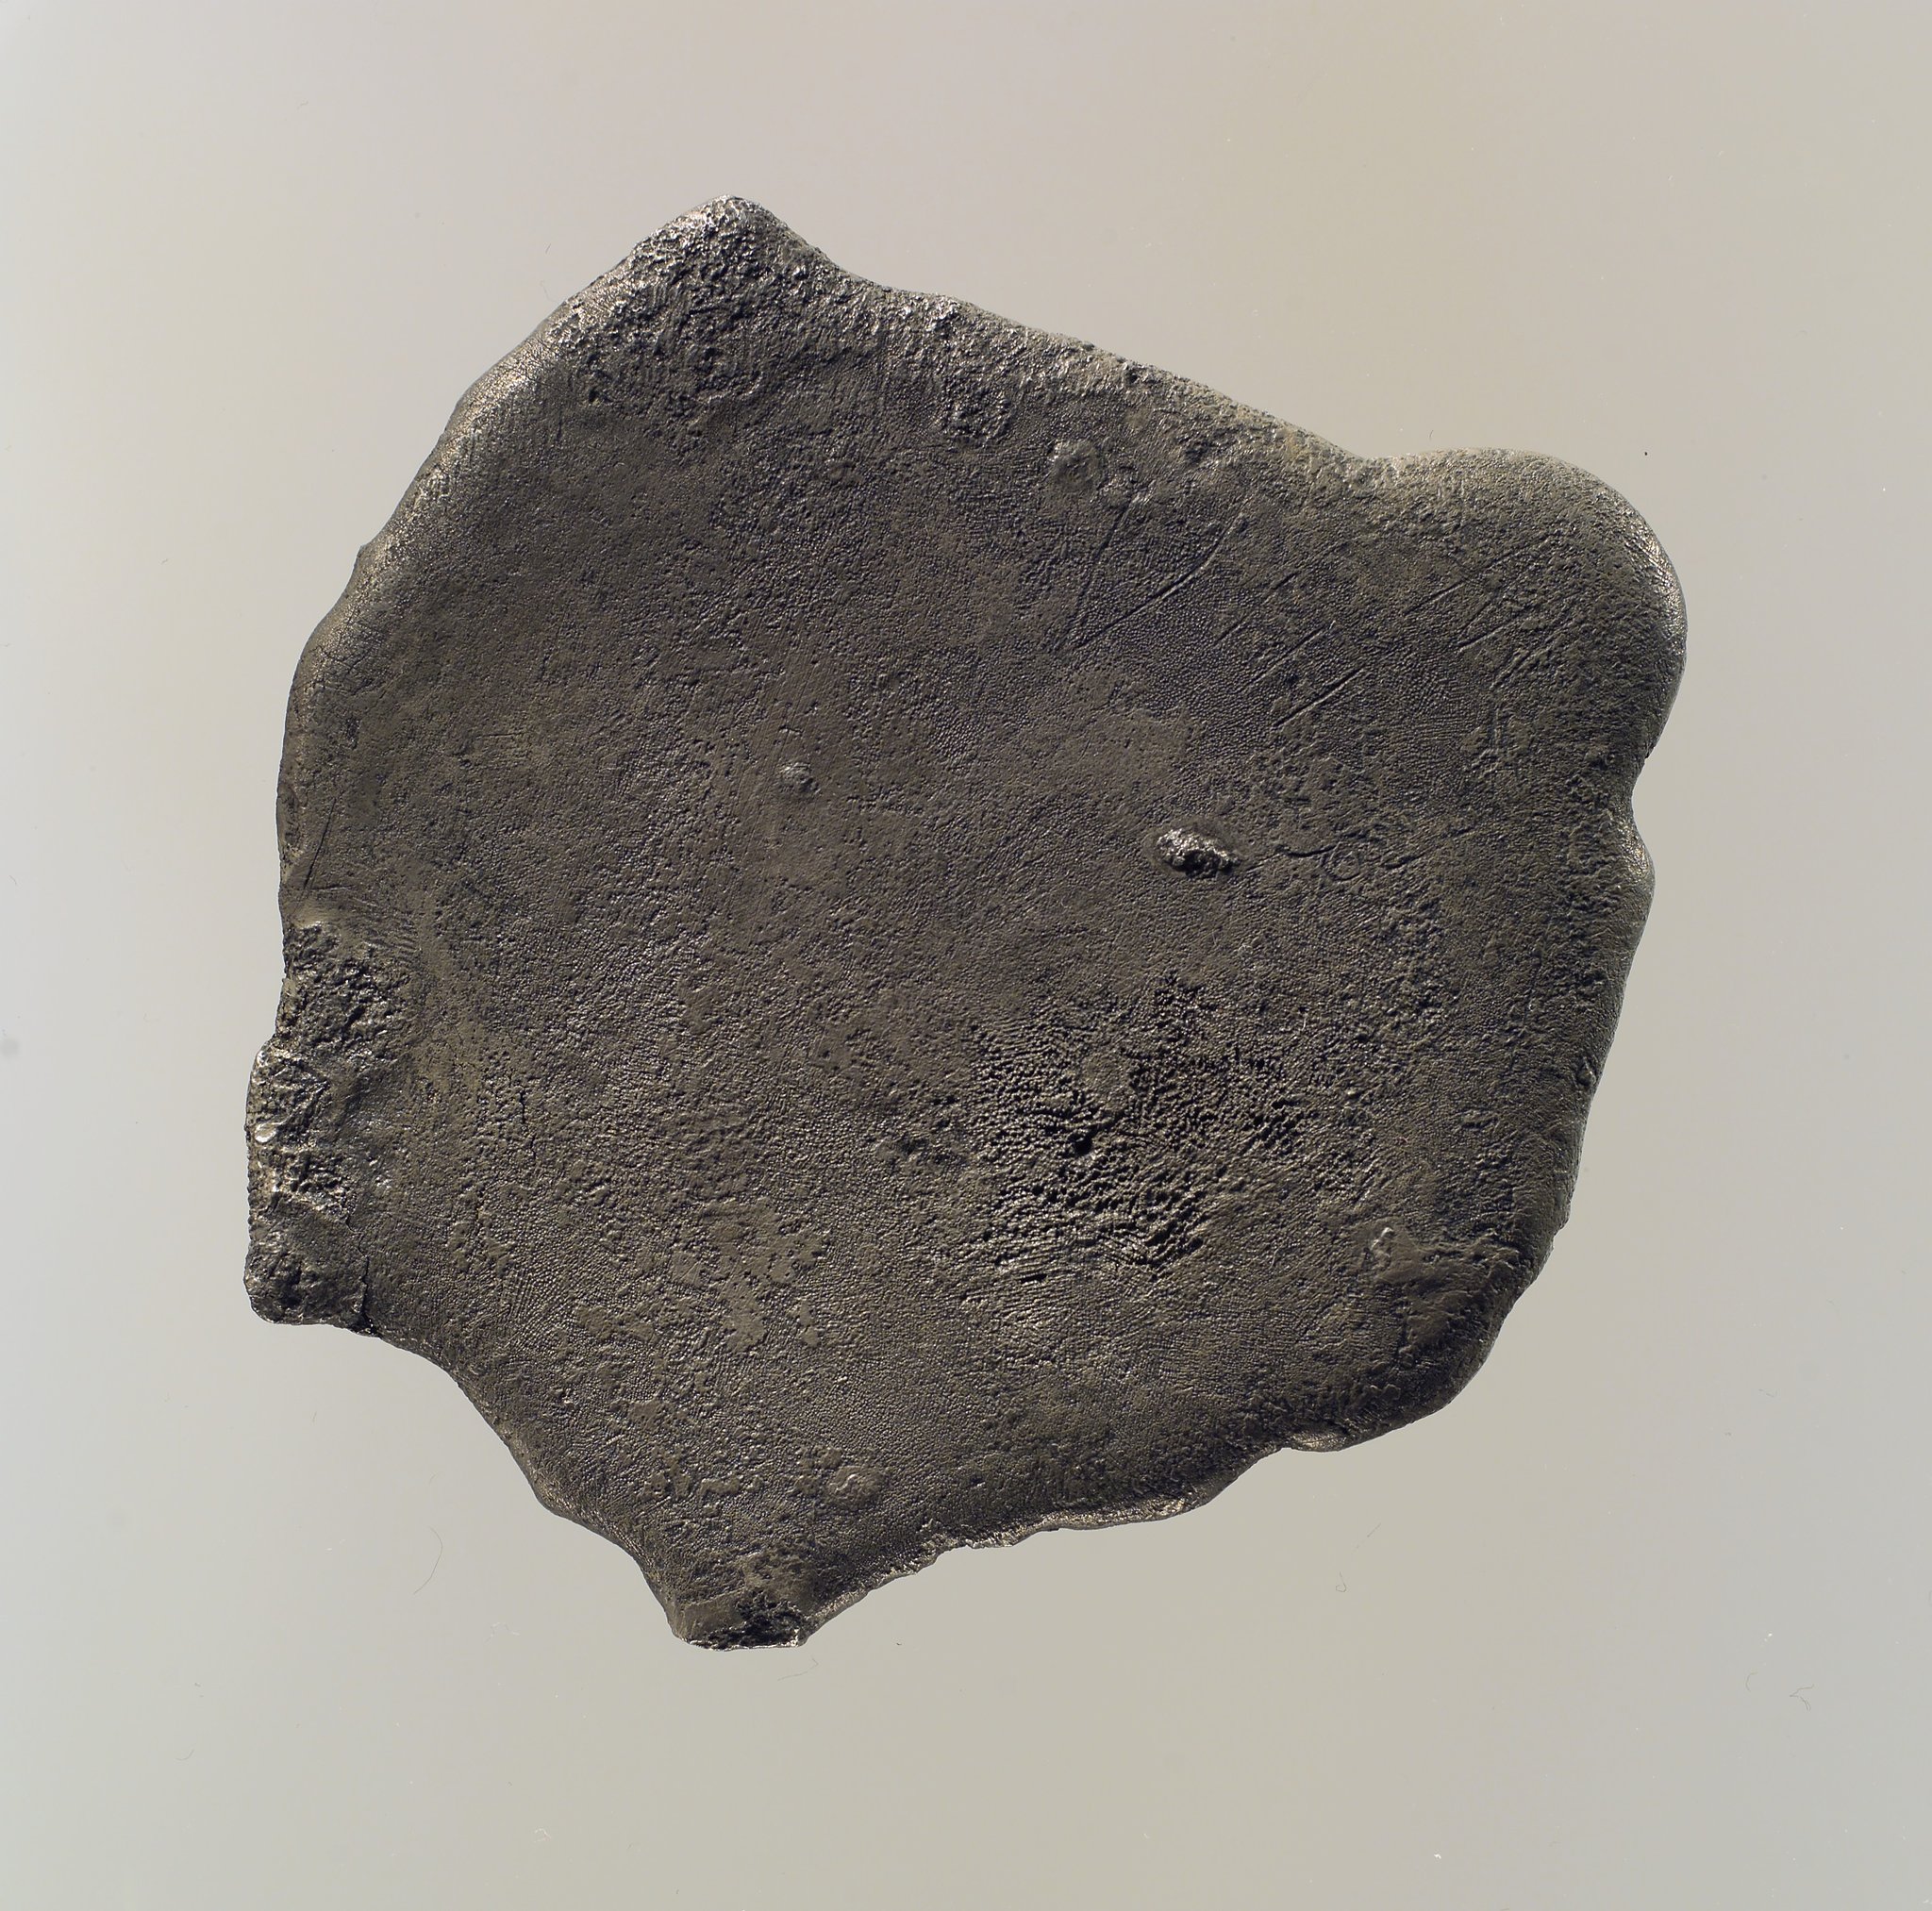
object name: ingot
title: Ingot with Hittite hieroglyphs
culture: hittite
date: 1400-1201 BCE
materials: silver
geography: central anatolia